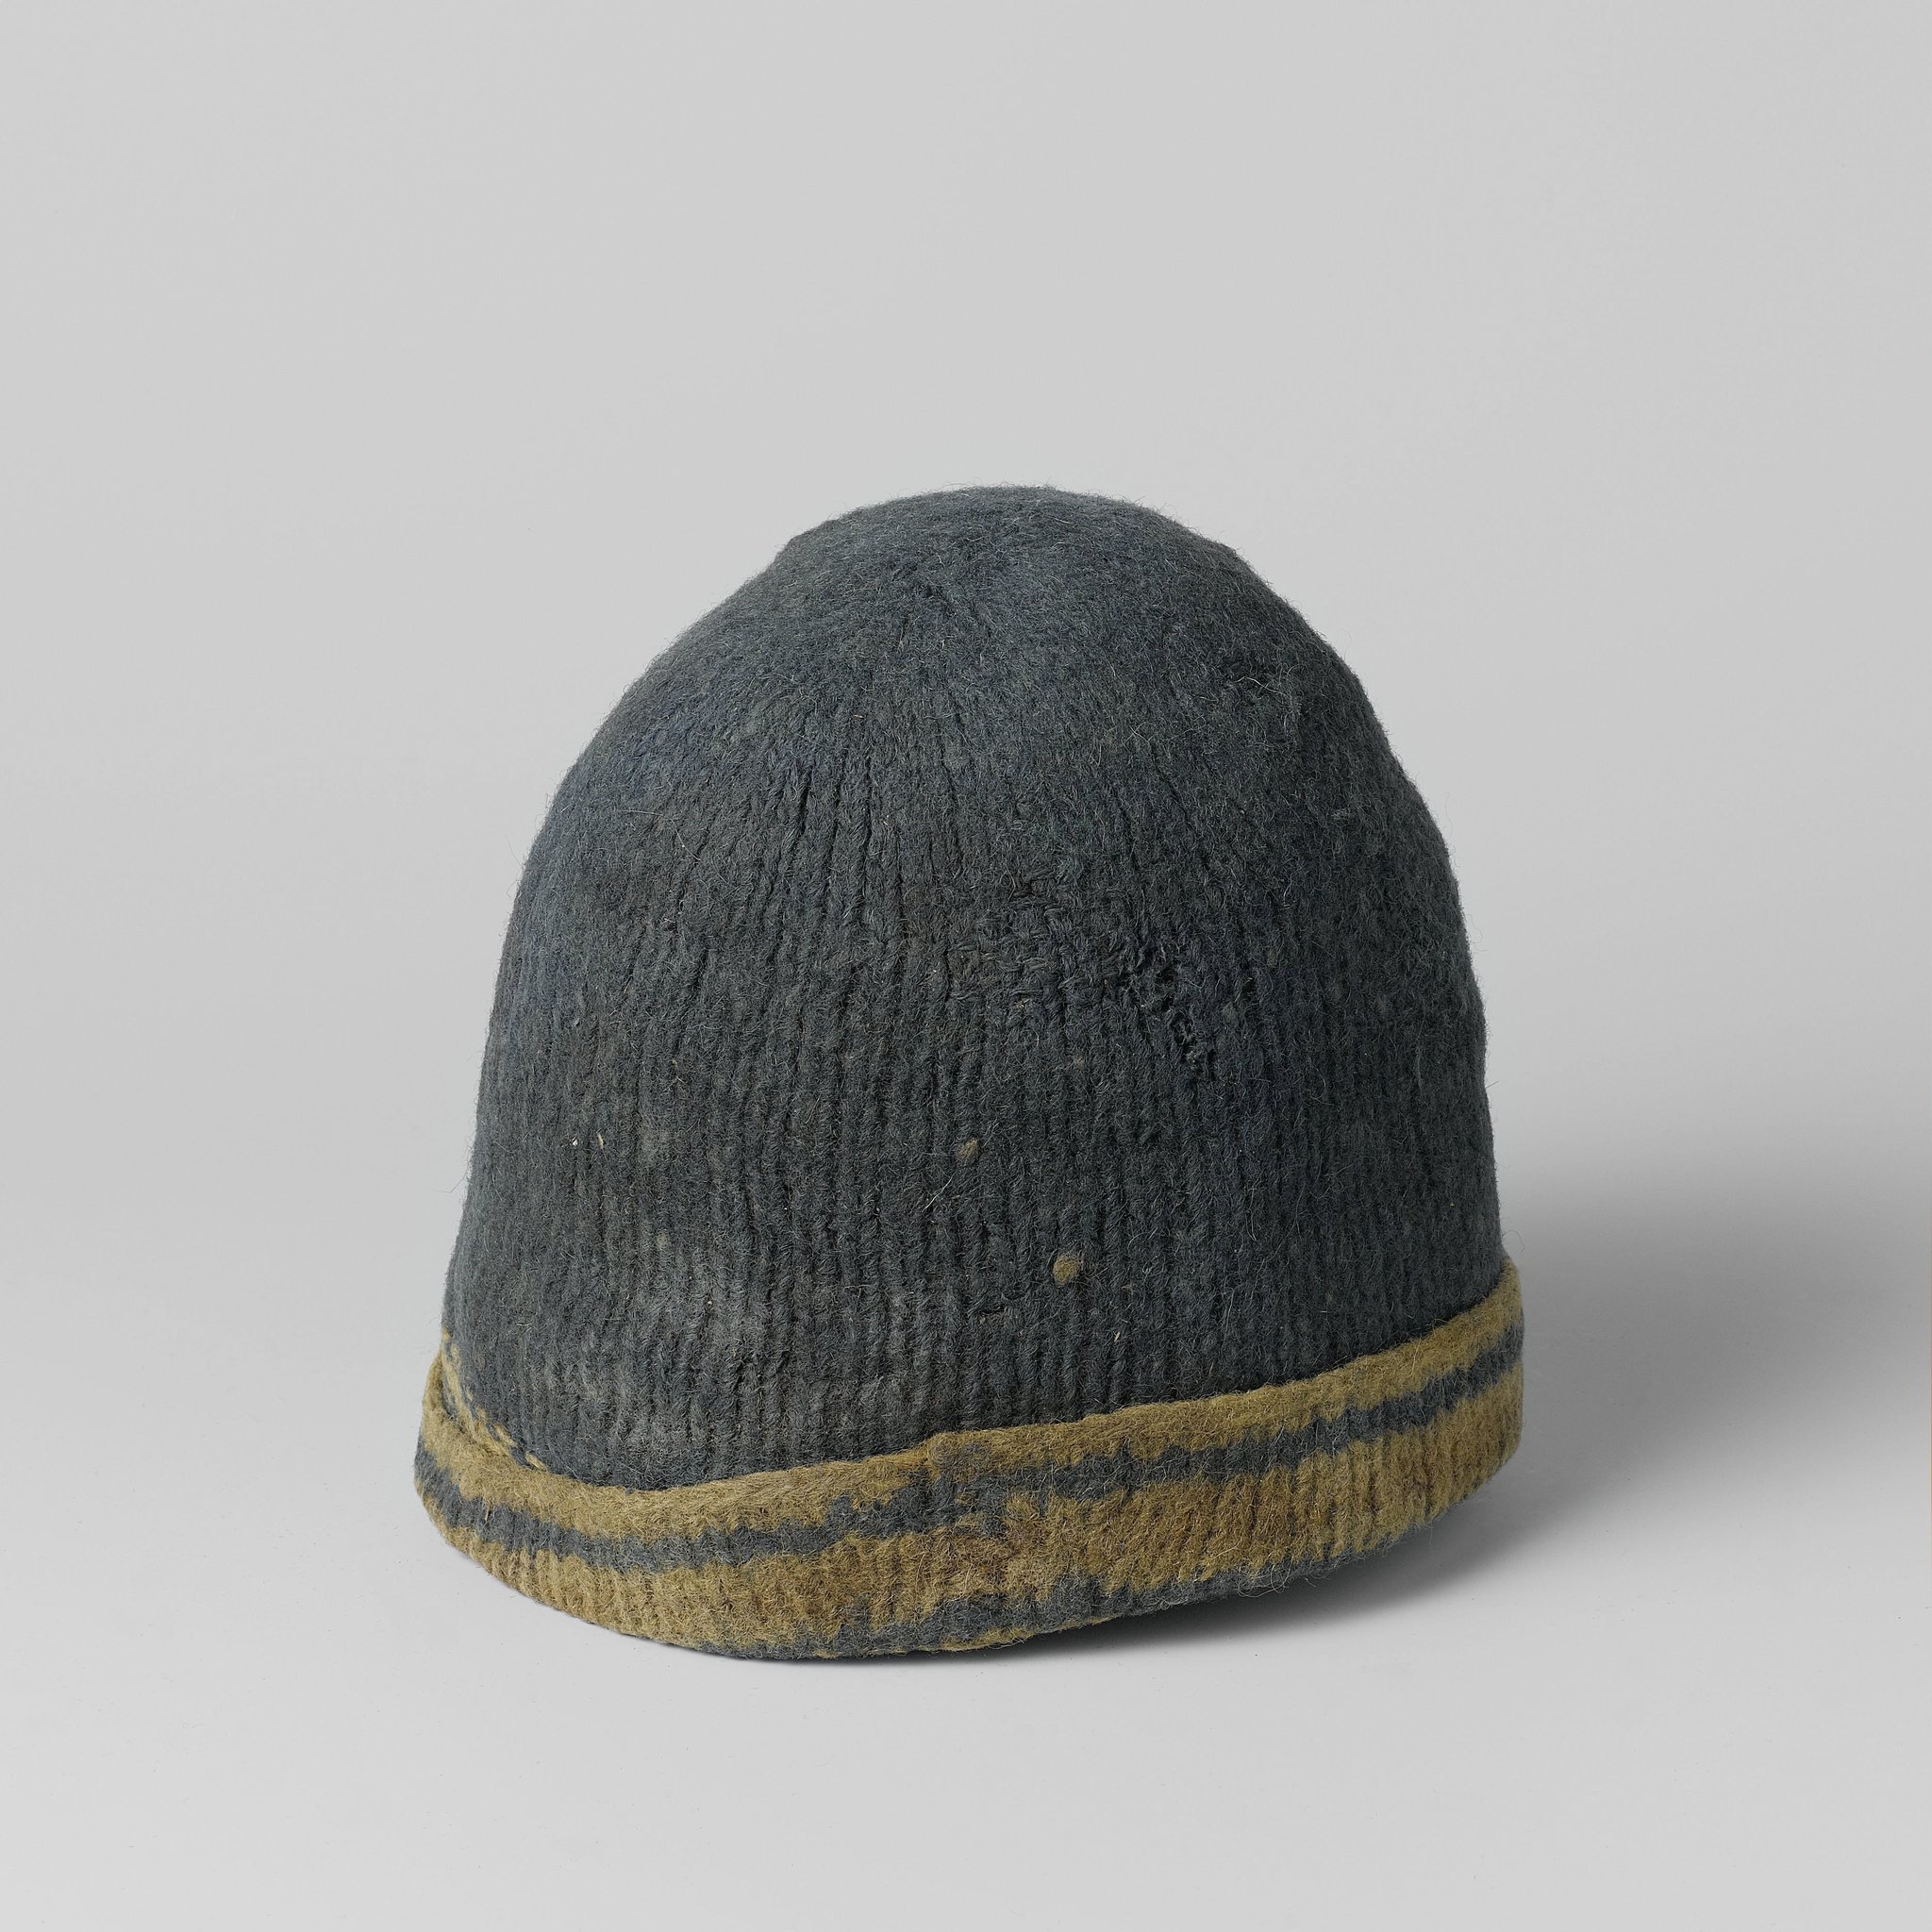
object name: cap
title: Woollen Caps Worn by Dutch Whalers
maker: Anonymous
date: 1650-1800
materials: wool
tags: noordse compagnie, spitsbergen, zeeuwsche uytkyck, svalbard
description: In 1980 archaeologists investigated the graves of 185 Dutchmen – whale hunters, and workers at whale oil refineries – who had died on or near Spitsbergen in the 17th century. Many skeletons were still wearing their knitted woollen head coverings. These caps were highly personal. The men were bundled up against the severe cold and could only be recognized by the colours and patterns of their caps. Presumably this is the reason why the caps went with them into their graves.